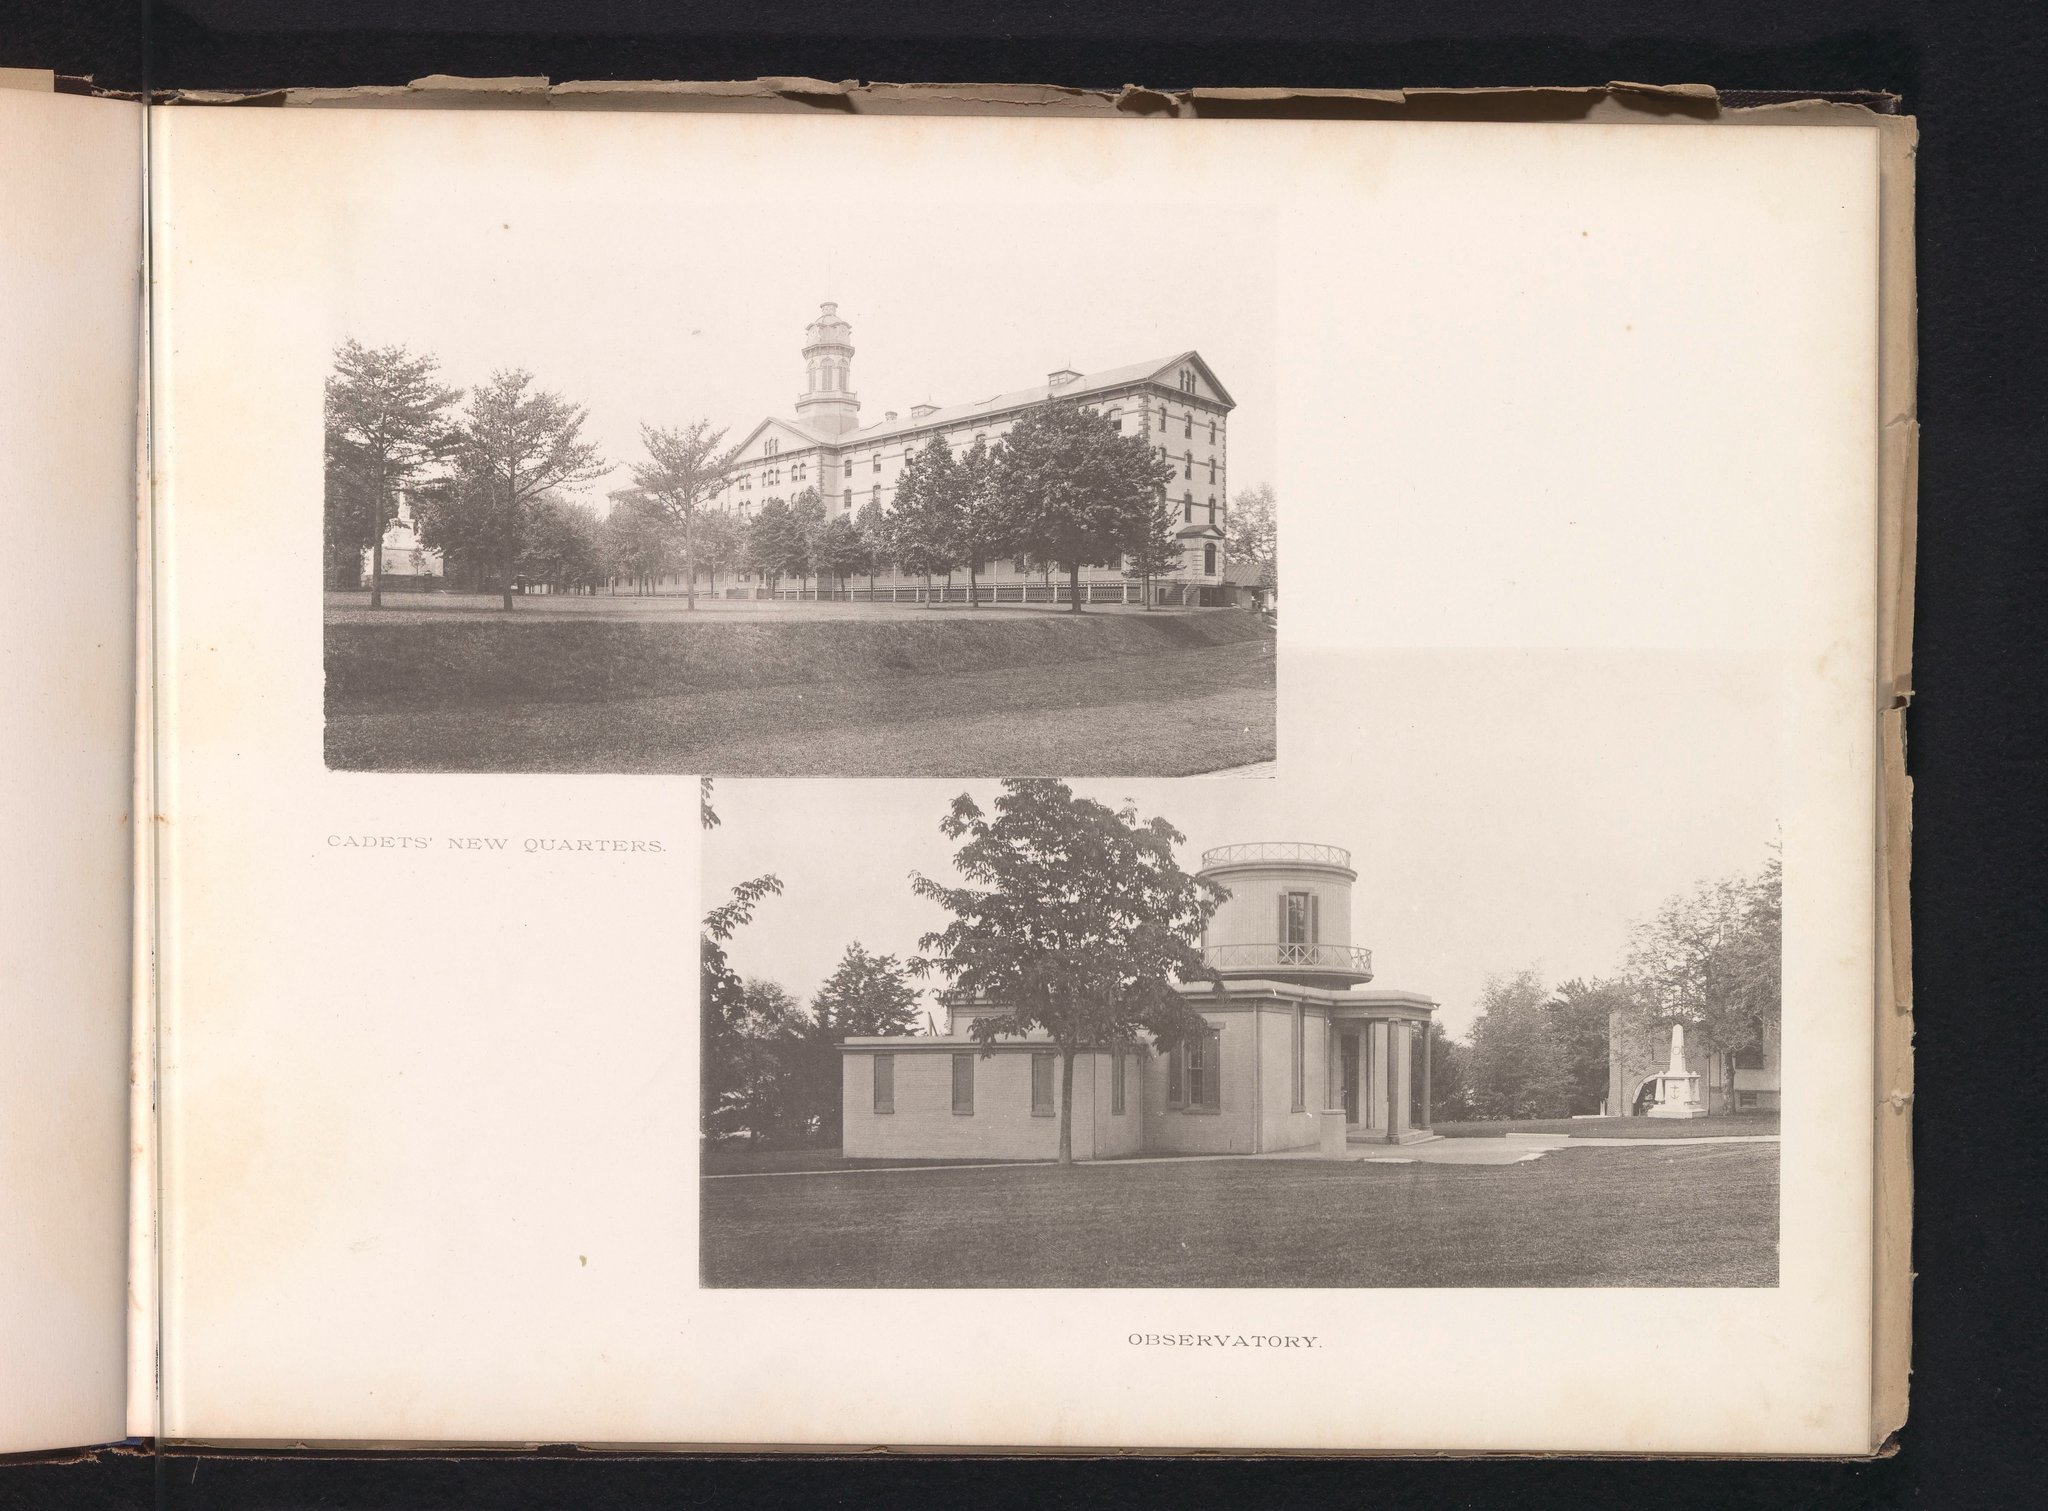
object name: page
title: Cadet's new quarters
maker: edward h. hart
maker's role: publisher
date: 1885-1890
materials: paper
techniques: photograph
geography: new york city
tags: meteorological observatory, military academy, façade (of house or building), shelter ~ military service